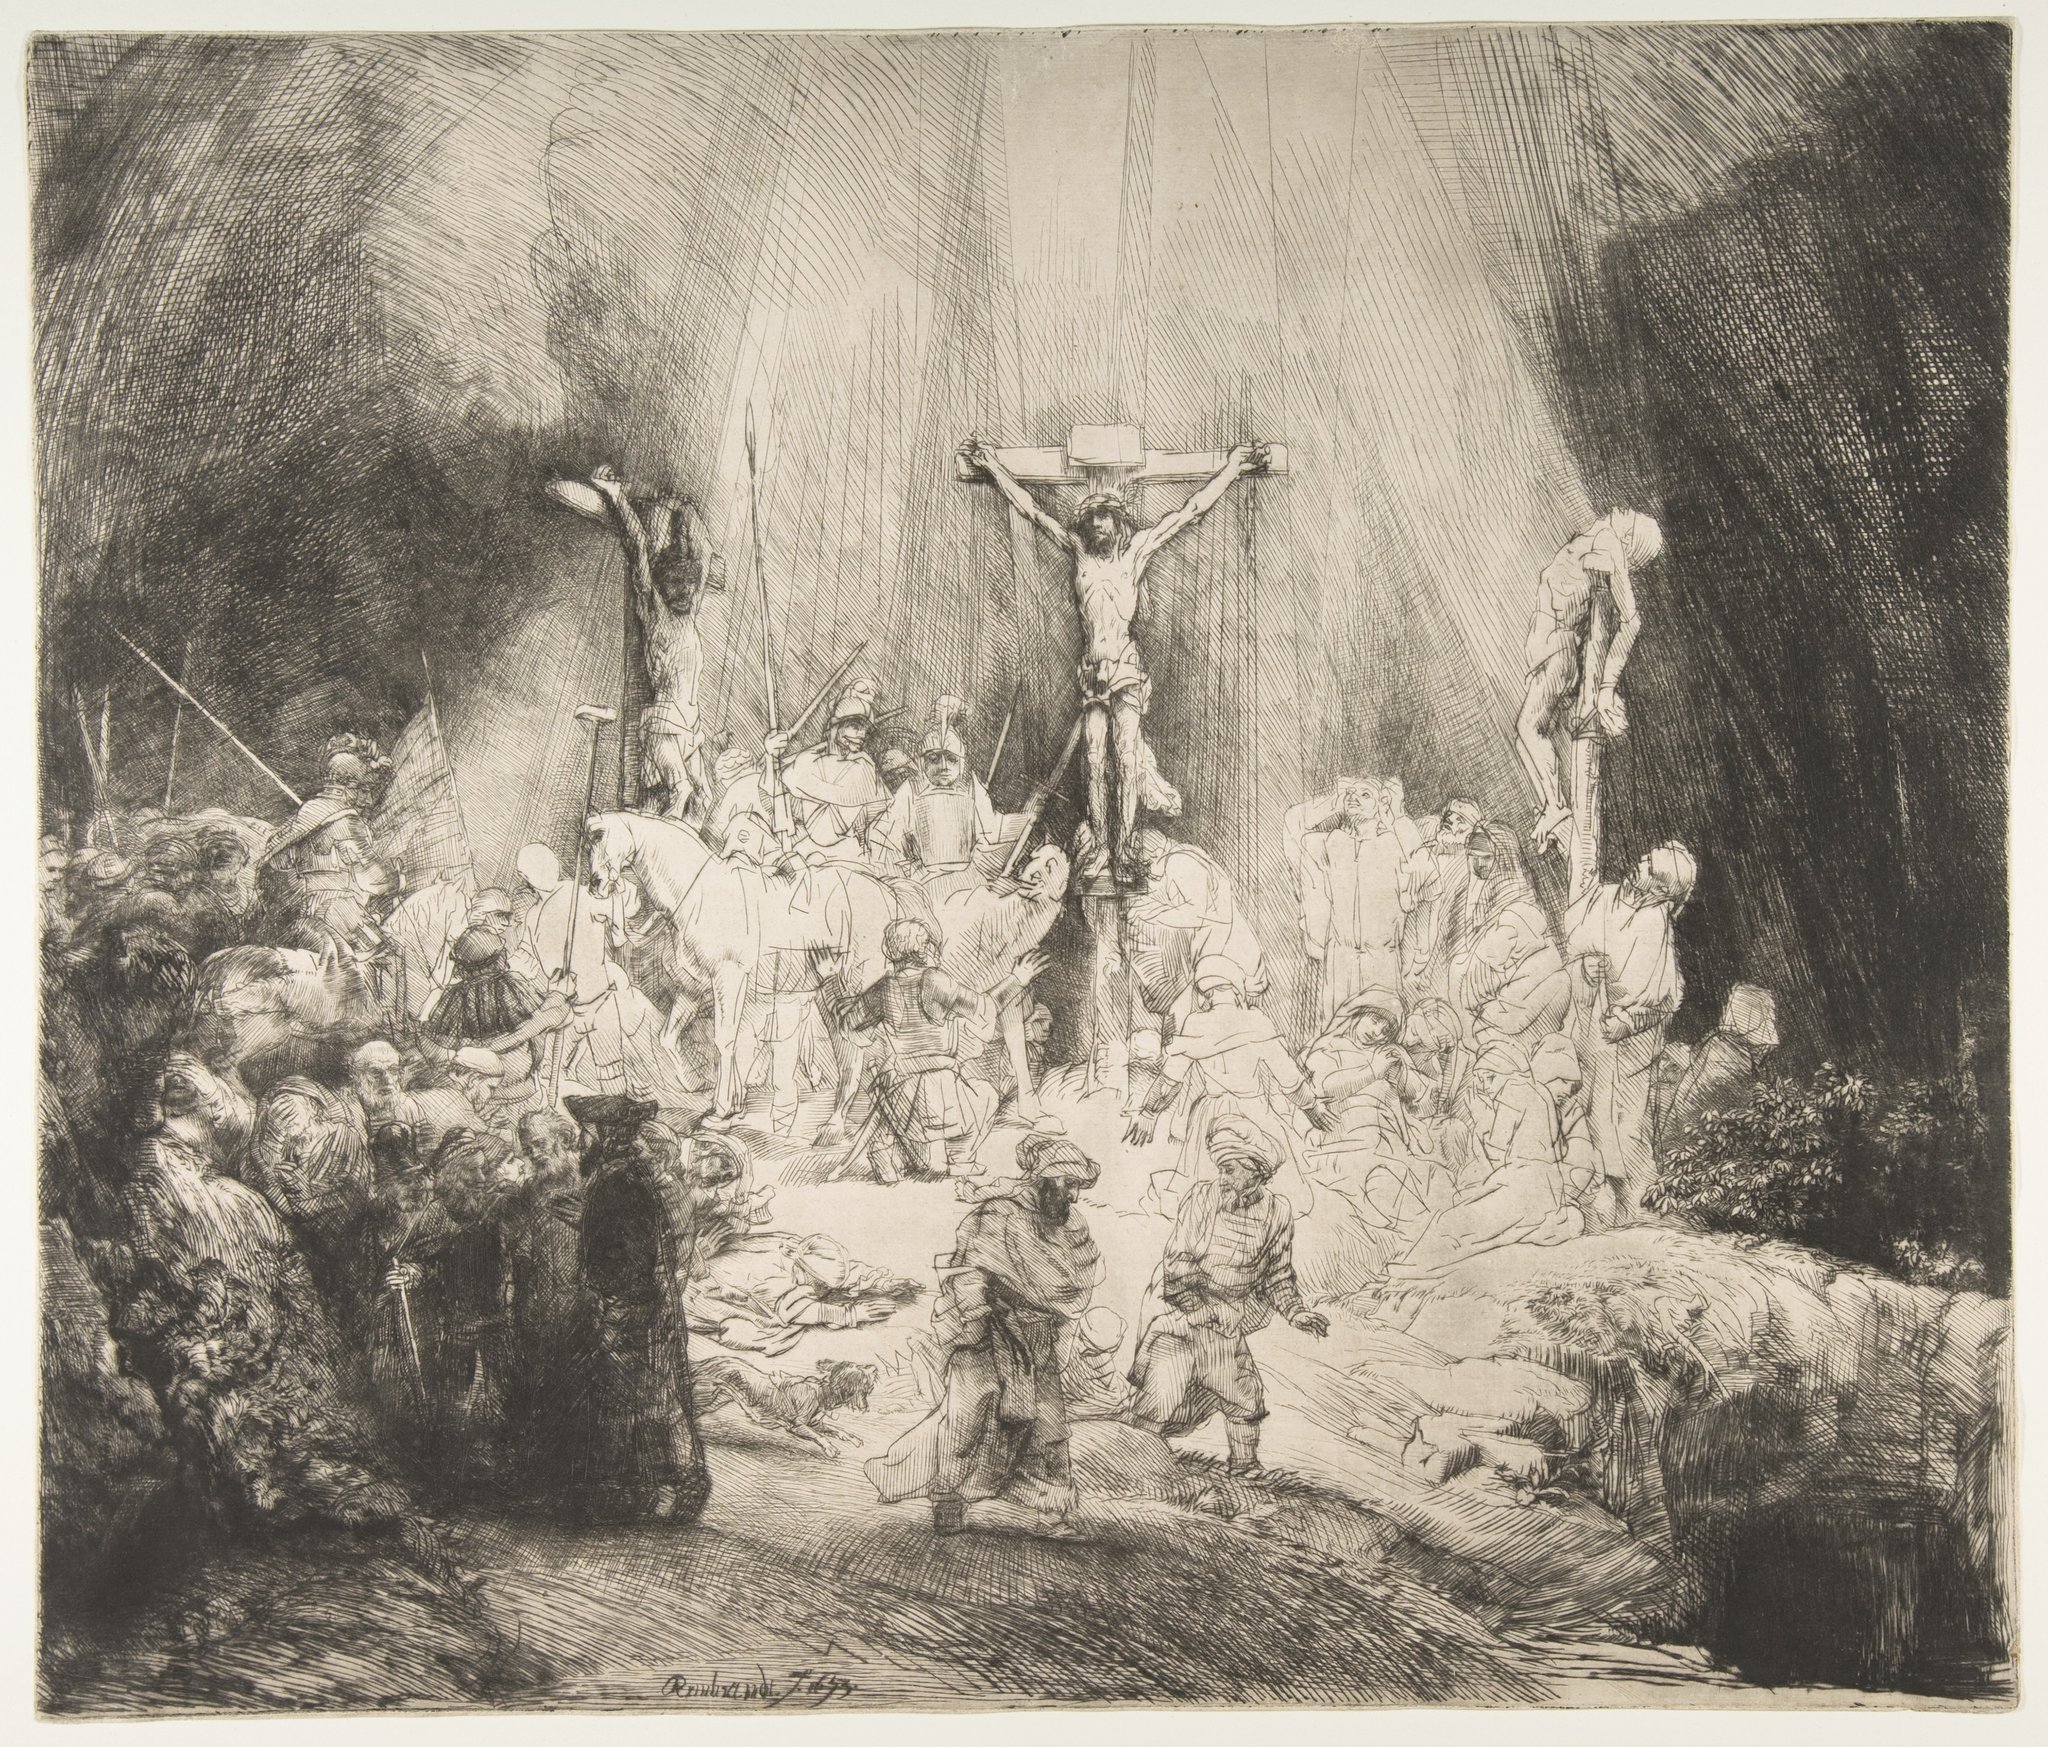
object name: print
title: Christ Crucified between the Two Thieves: The Three Crosses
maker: rembrandt van rijn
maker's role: artist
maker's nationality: dutch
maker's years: 1606-1669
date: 1653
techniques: drypoint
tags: men,christ,crucifixion